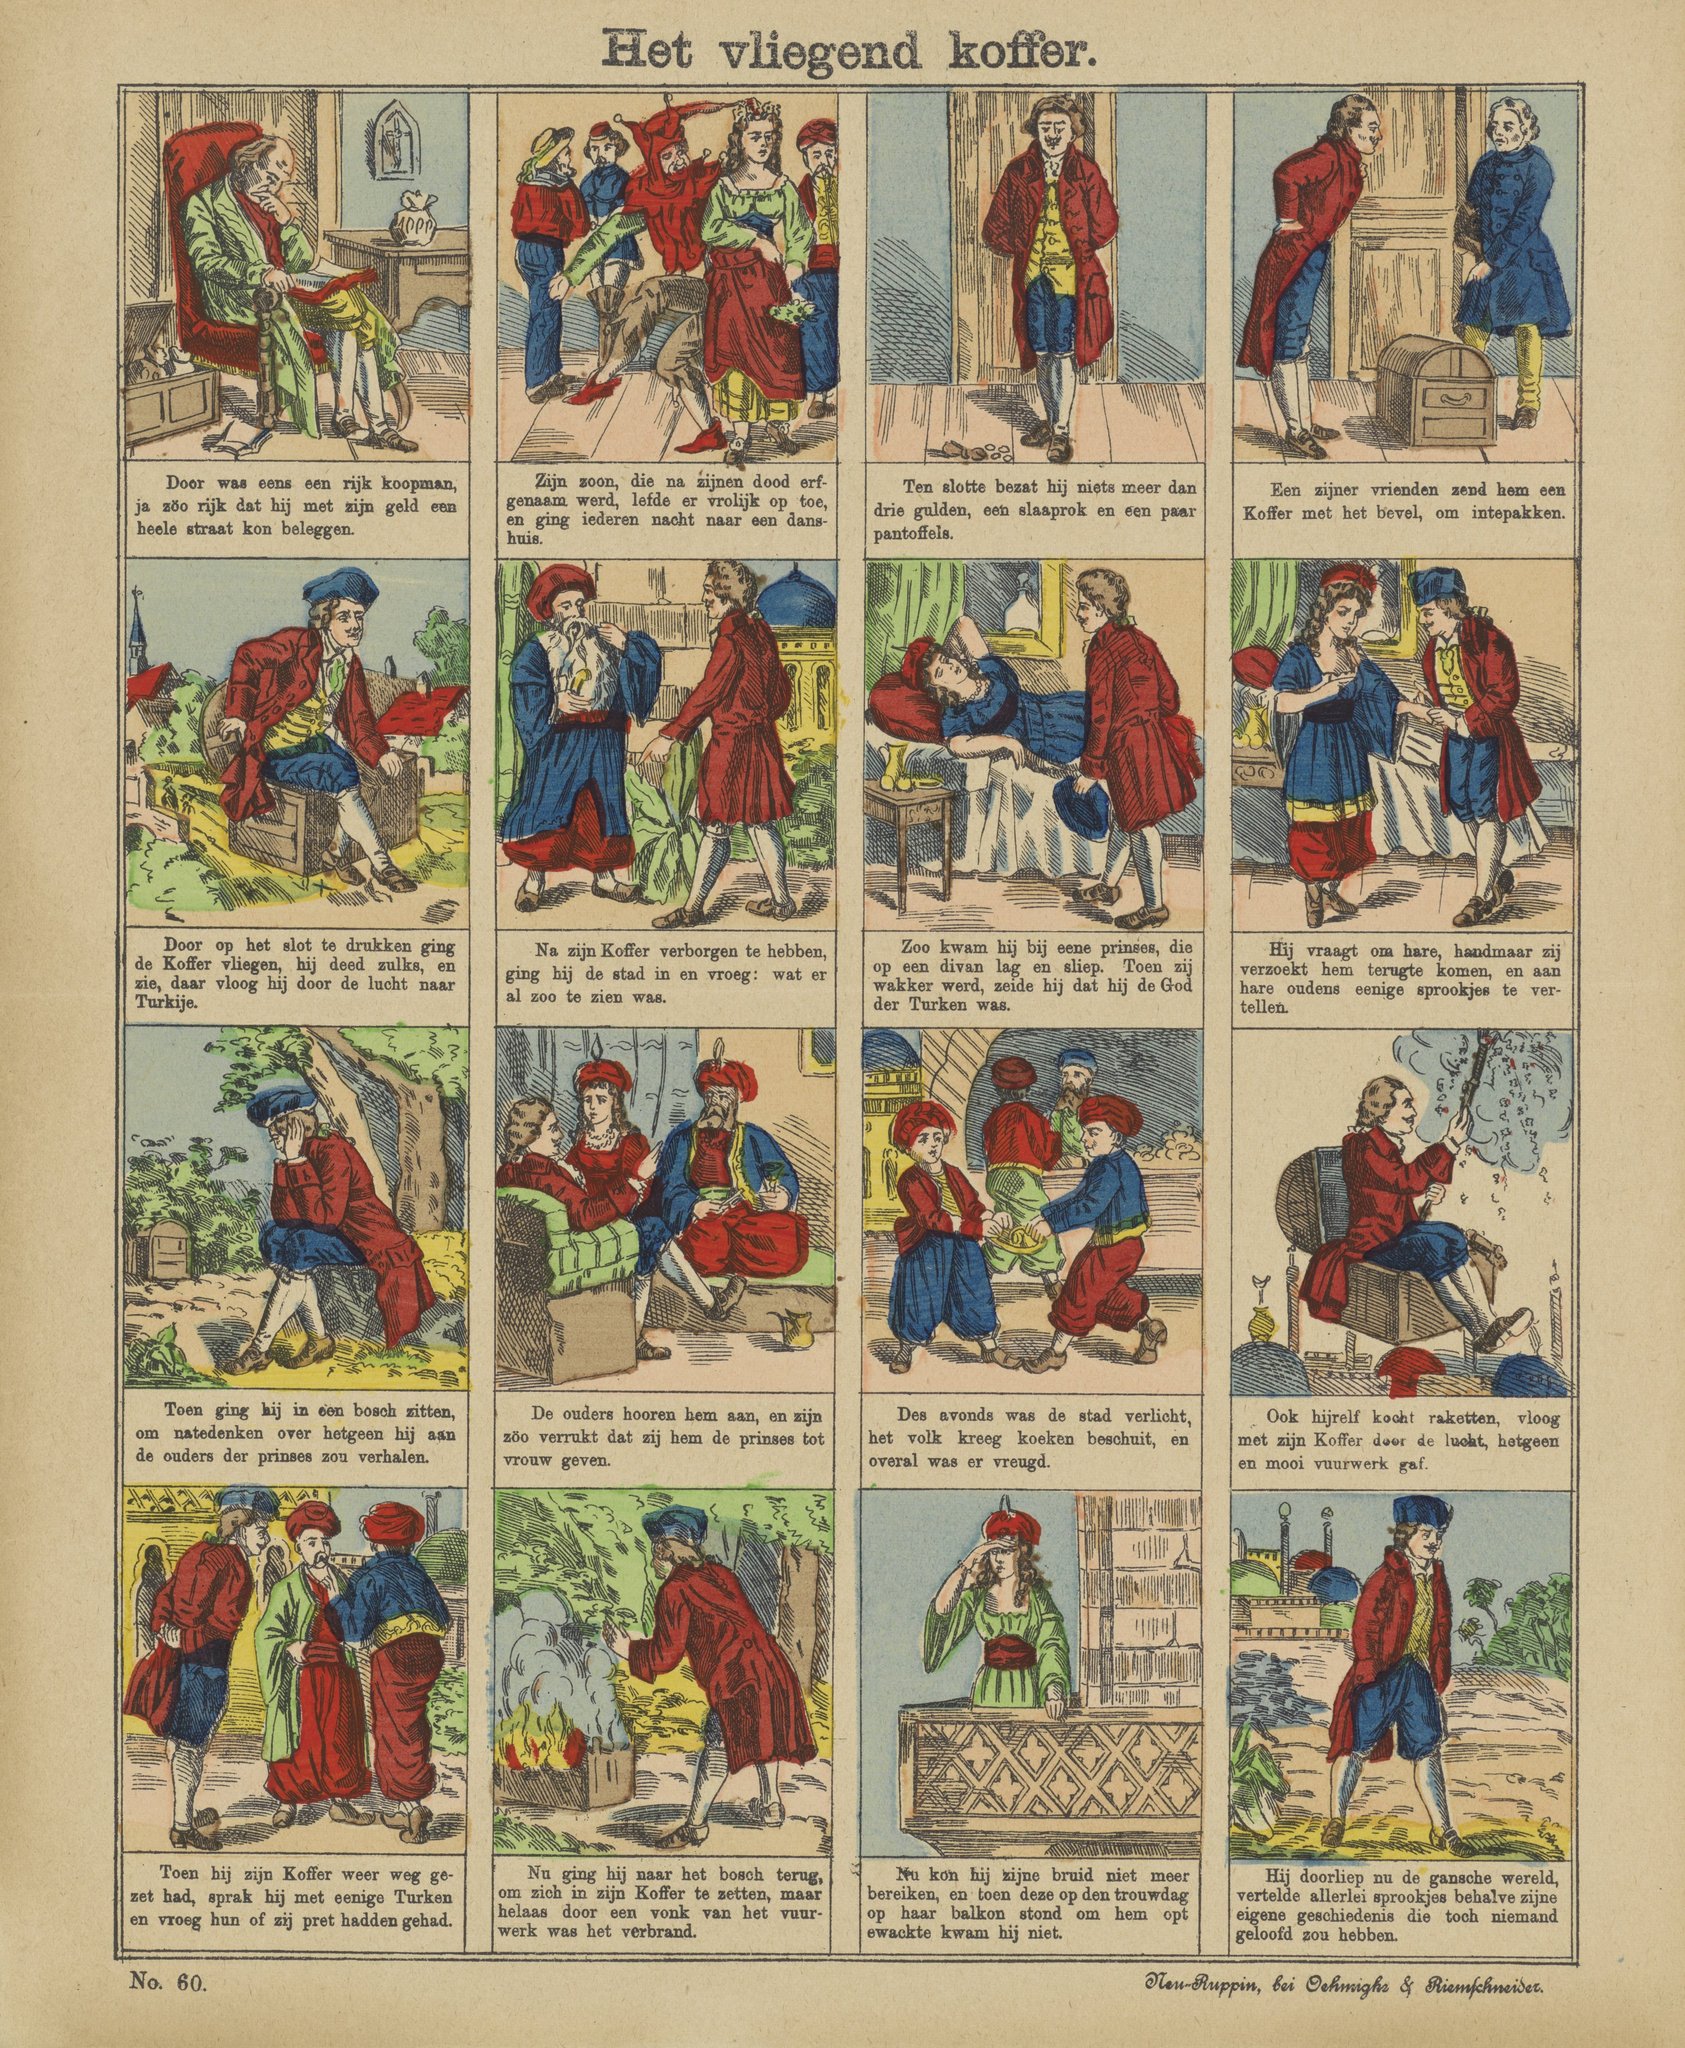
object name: popular print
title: Het vliegend koffer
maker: Anonymous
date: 1828-1937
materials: paper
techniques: hand coloring, letterpress printing, lithograph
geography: neuruppin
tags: tales and fairy tales, trunk, suit-case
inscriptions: collector's mark: Lugt 2760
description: Blad met 16 voorstellingen uit het verhaal van de vliegende koffer. Onder elke afbeelding een onderschrift. Genummerd linksonder: No. 60.